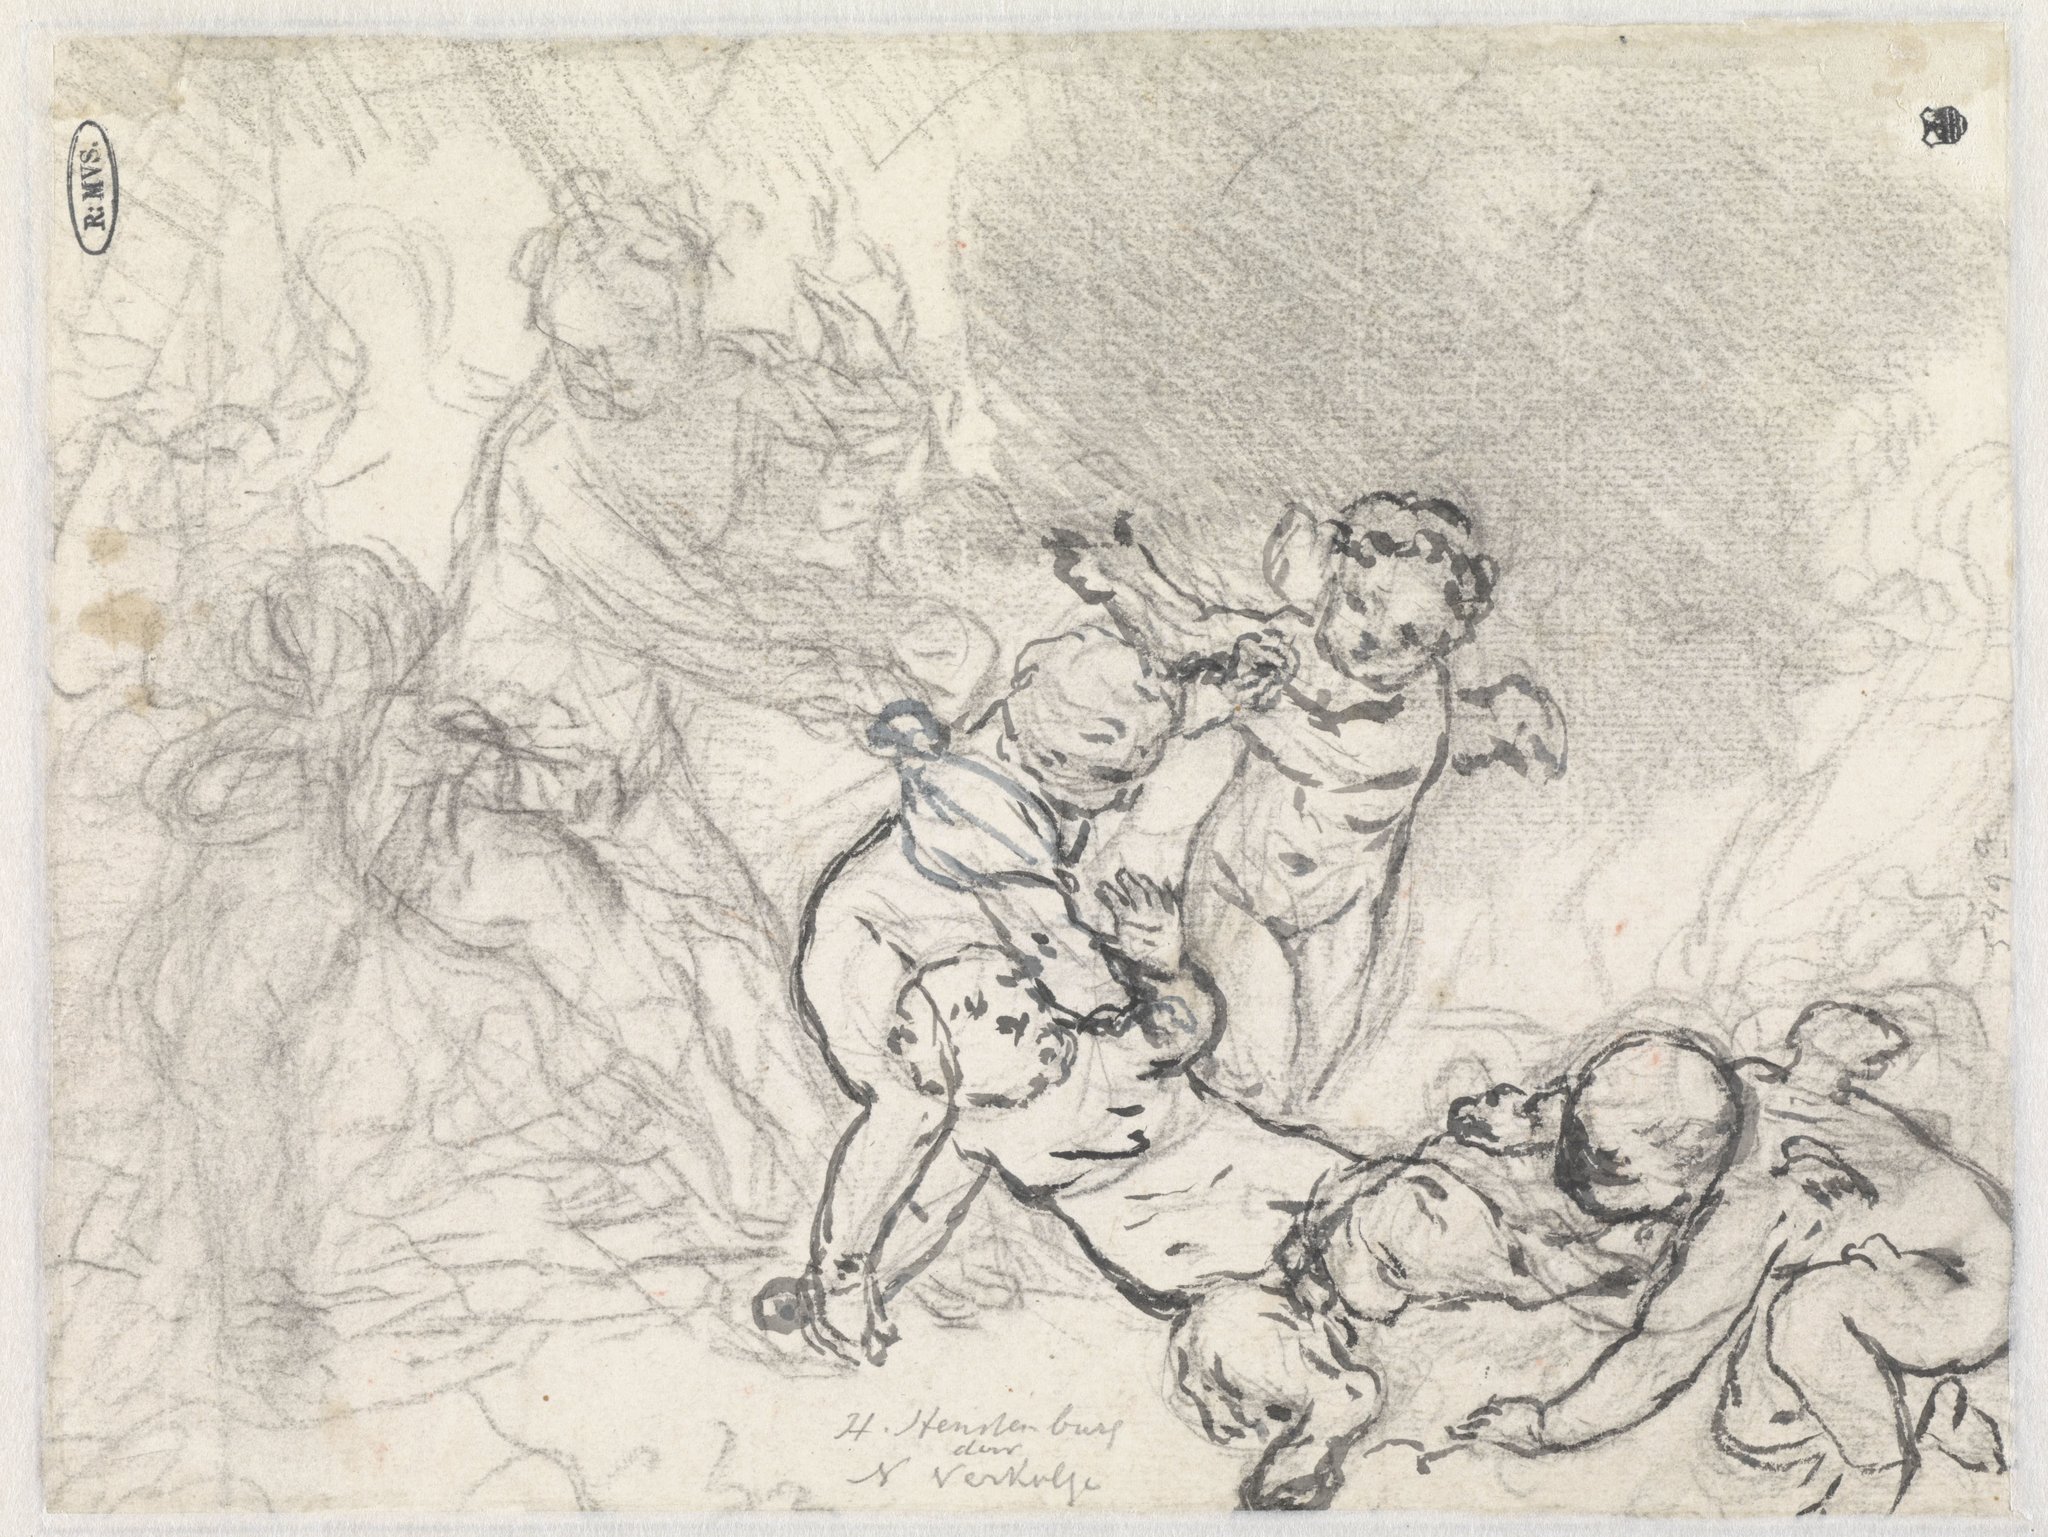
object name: drawing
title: Schetsblad met vrouw en putti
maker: nicolaas verkolje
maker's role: draughtsman, painter, print maker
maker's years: 1673-1746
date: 1720-1725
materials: chalk, paper, pencil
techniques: brush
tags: female sex; woman, cupids: 'amores', 'amoretti', 'putti'